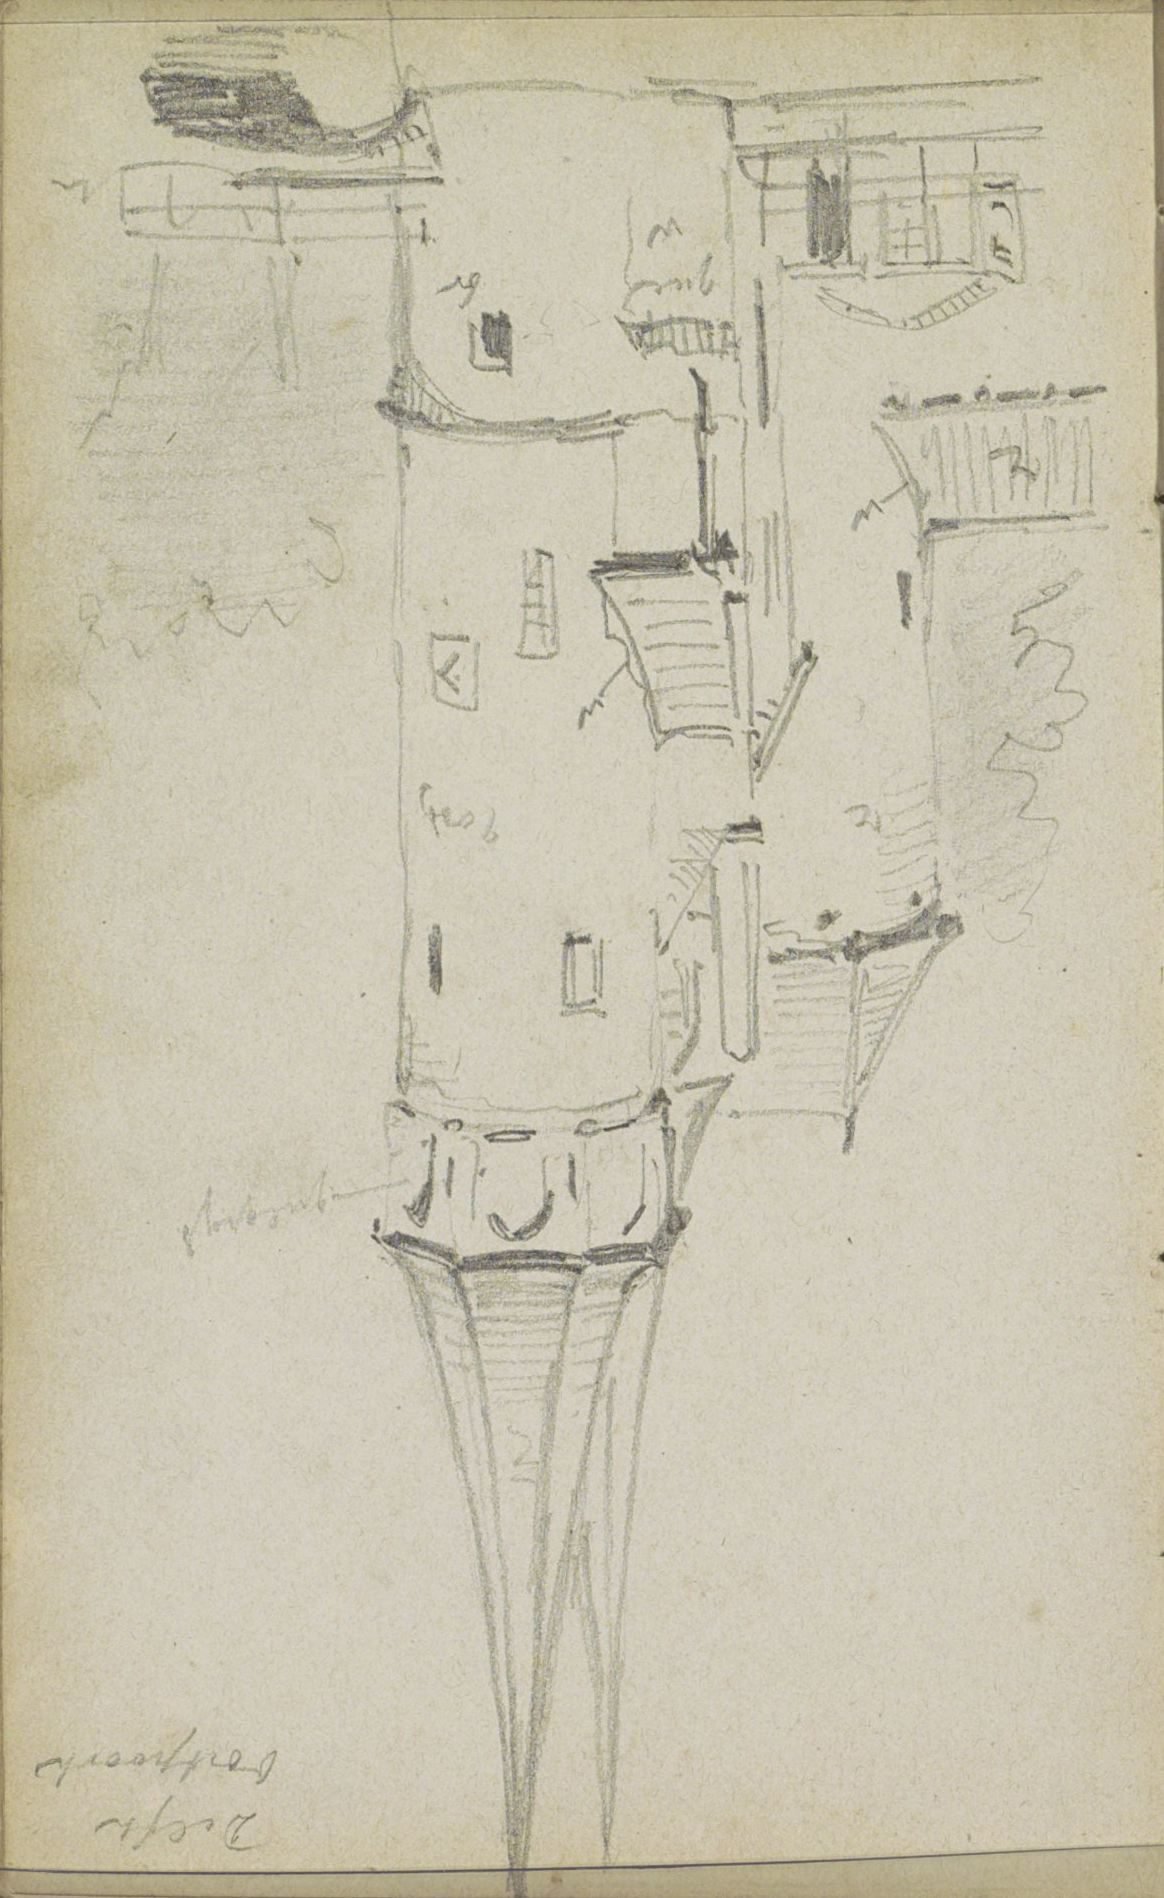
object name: sketchbook leaf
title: Gezicht op de Oostpoort te Delft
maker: adrianus eversen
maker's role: draughtsman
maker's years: 1818-1897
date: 1828-1897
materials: paper, pencil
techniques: stumping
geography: delft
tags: city-gate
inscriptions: annotation: ‘Delft/ Oostpoort’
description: Gezicht op de Oostpoort te Delft. Blad 68 verso uit een schetsboek met 69 bladen vervaardigd in de omgeving van Delft, Rotterdam, Oudewater en Harlingen.